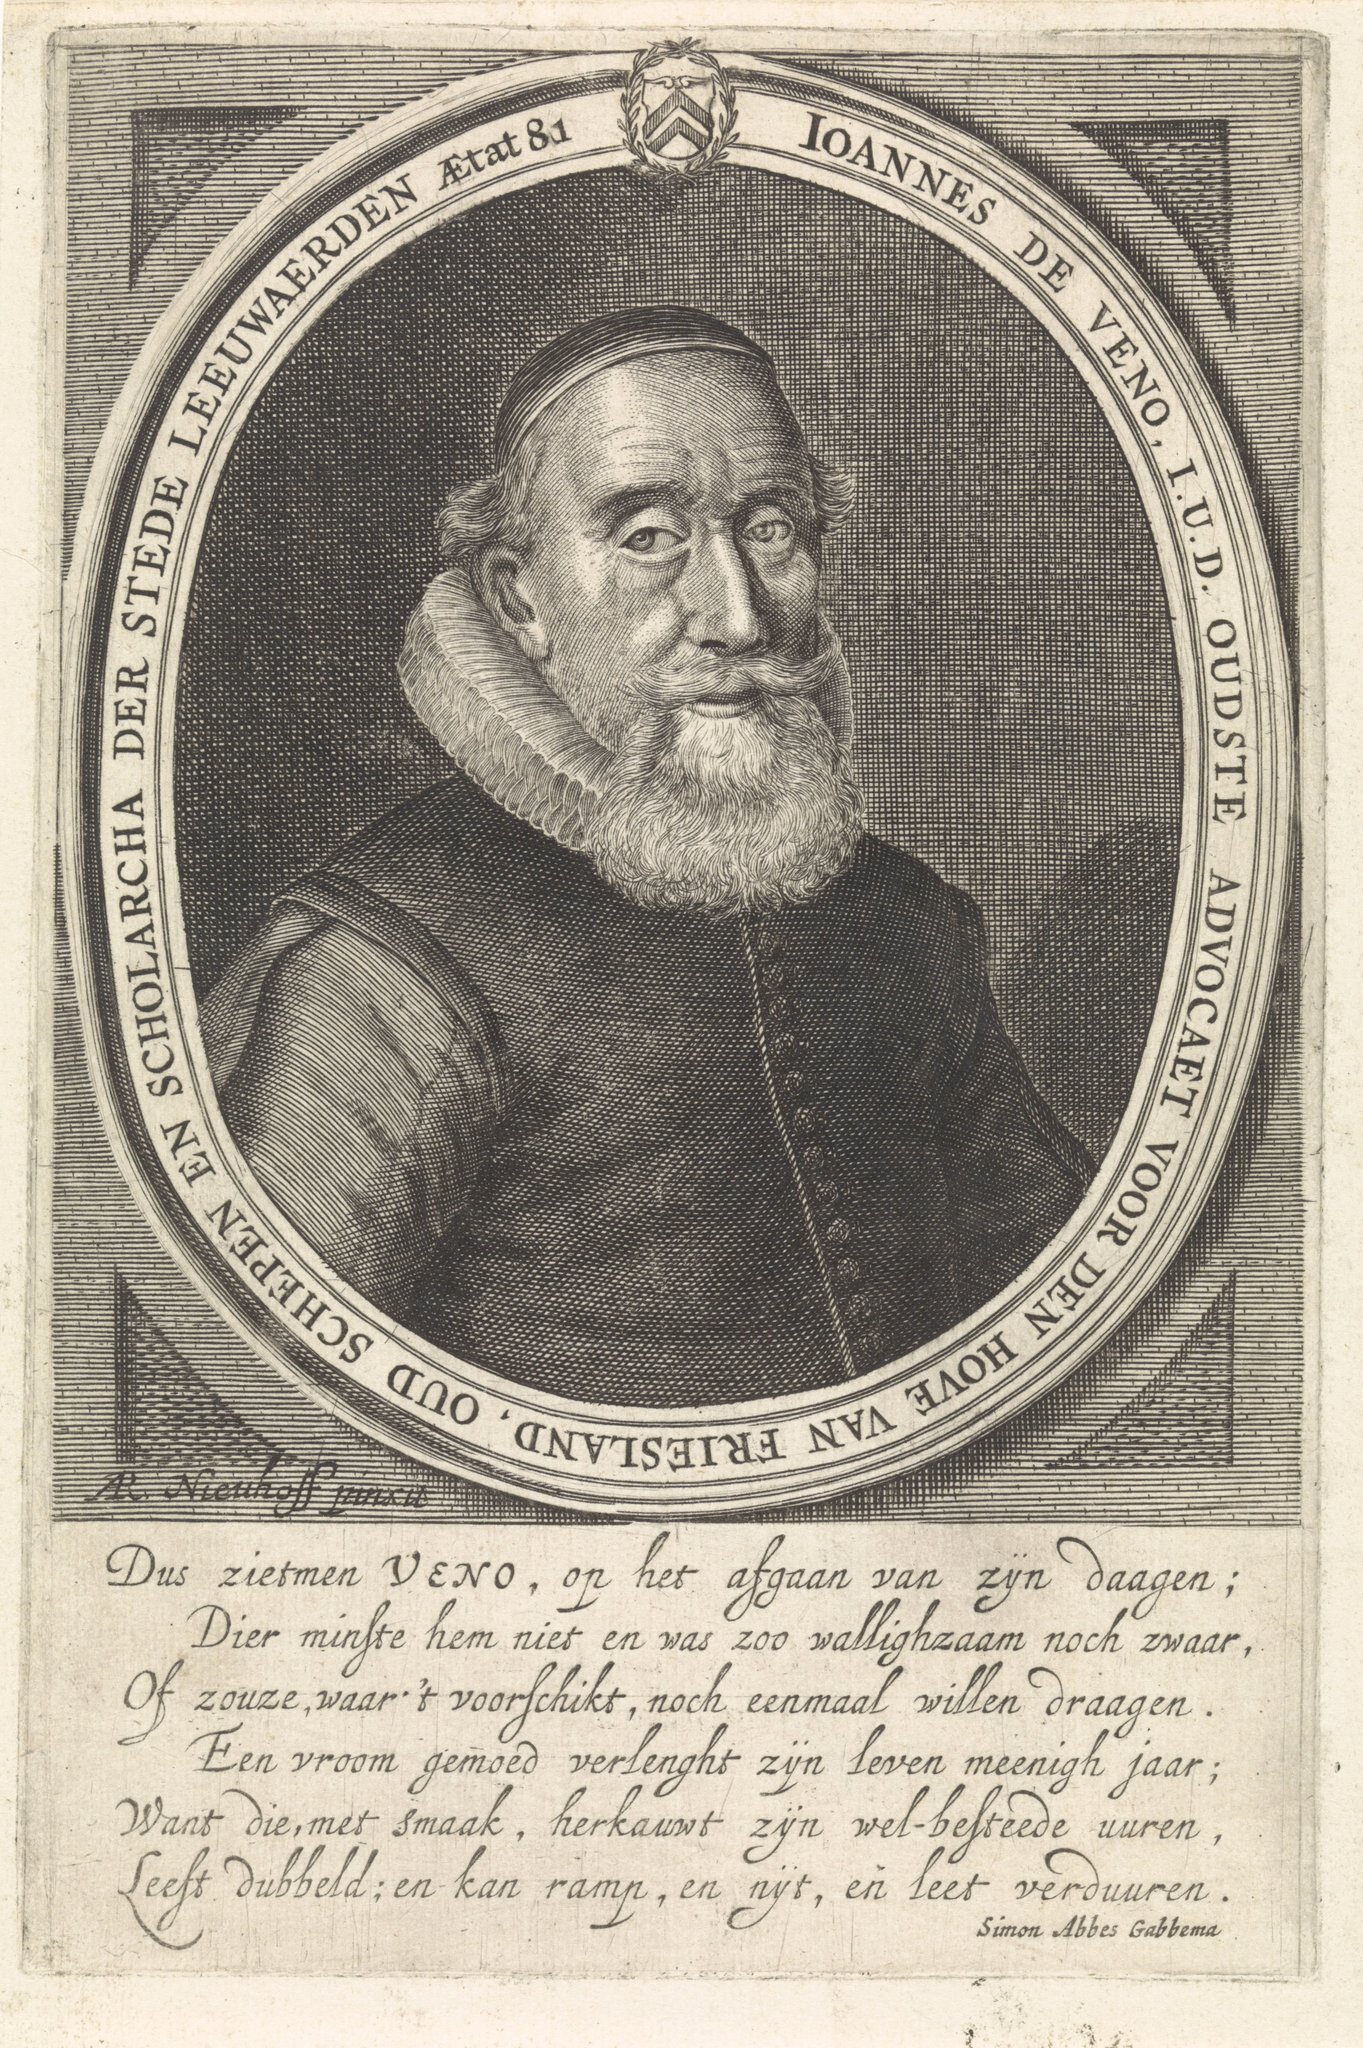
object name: print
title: Portret van Joannes de Veno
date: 1662-1664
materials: paper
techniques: engraving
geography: amsterdam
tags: joannes de veno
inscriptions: collector's mark: Lugt 2228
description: Portret van de advocaat Joannes de Veno, op 81-jarige leeftijd. Hij was schepen te Leeuwarden. In de marge een zesregelig lofdicht in het Nederlands.